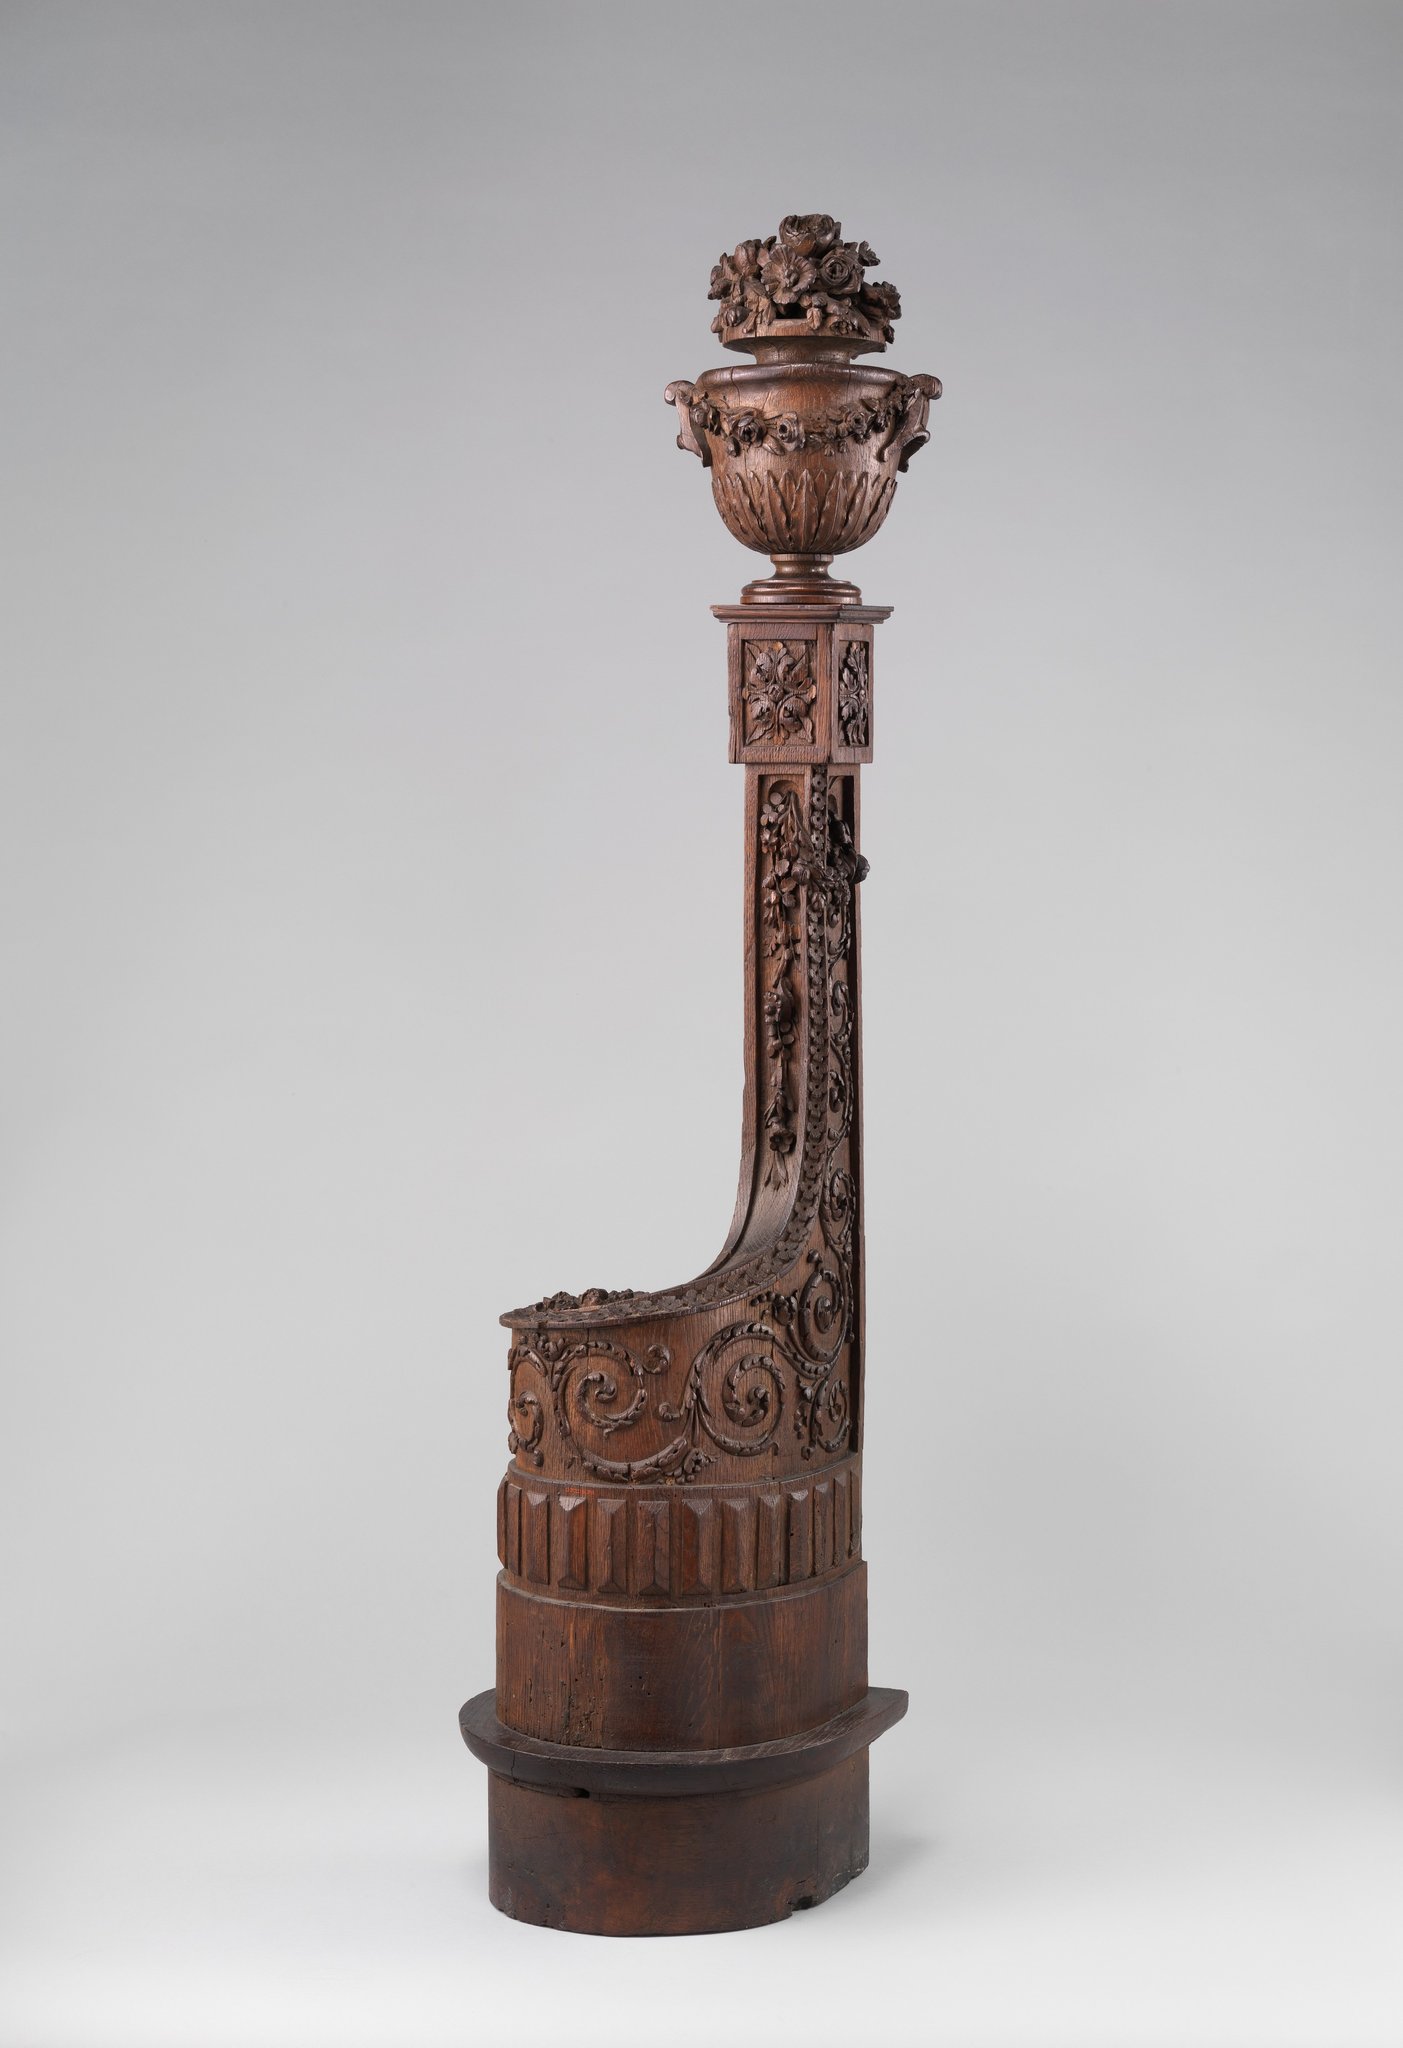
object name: newel post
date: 1701-1800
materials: wood, wax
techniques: polish